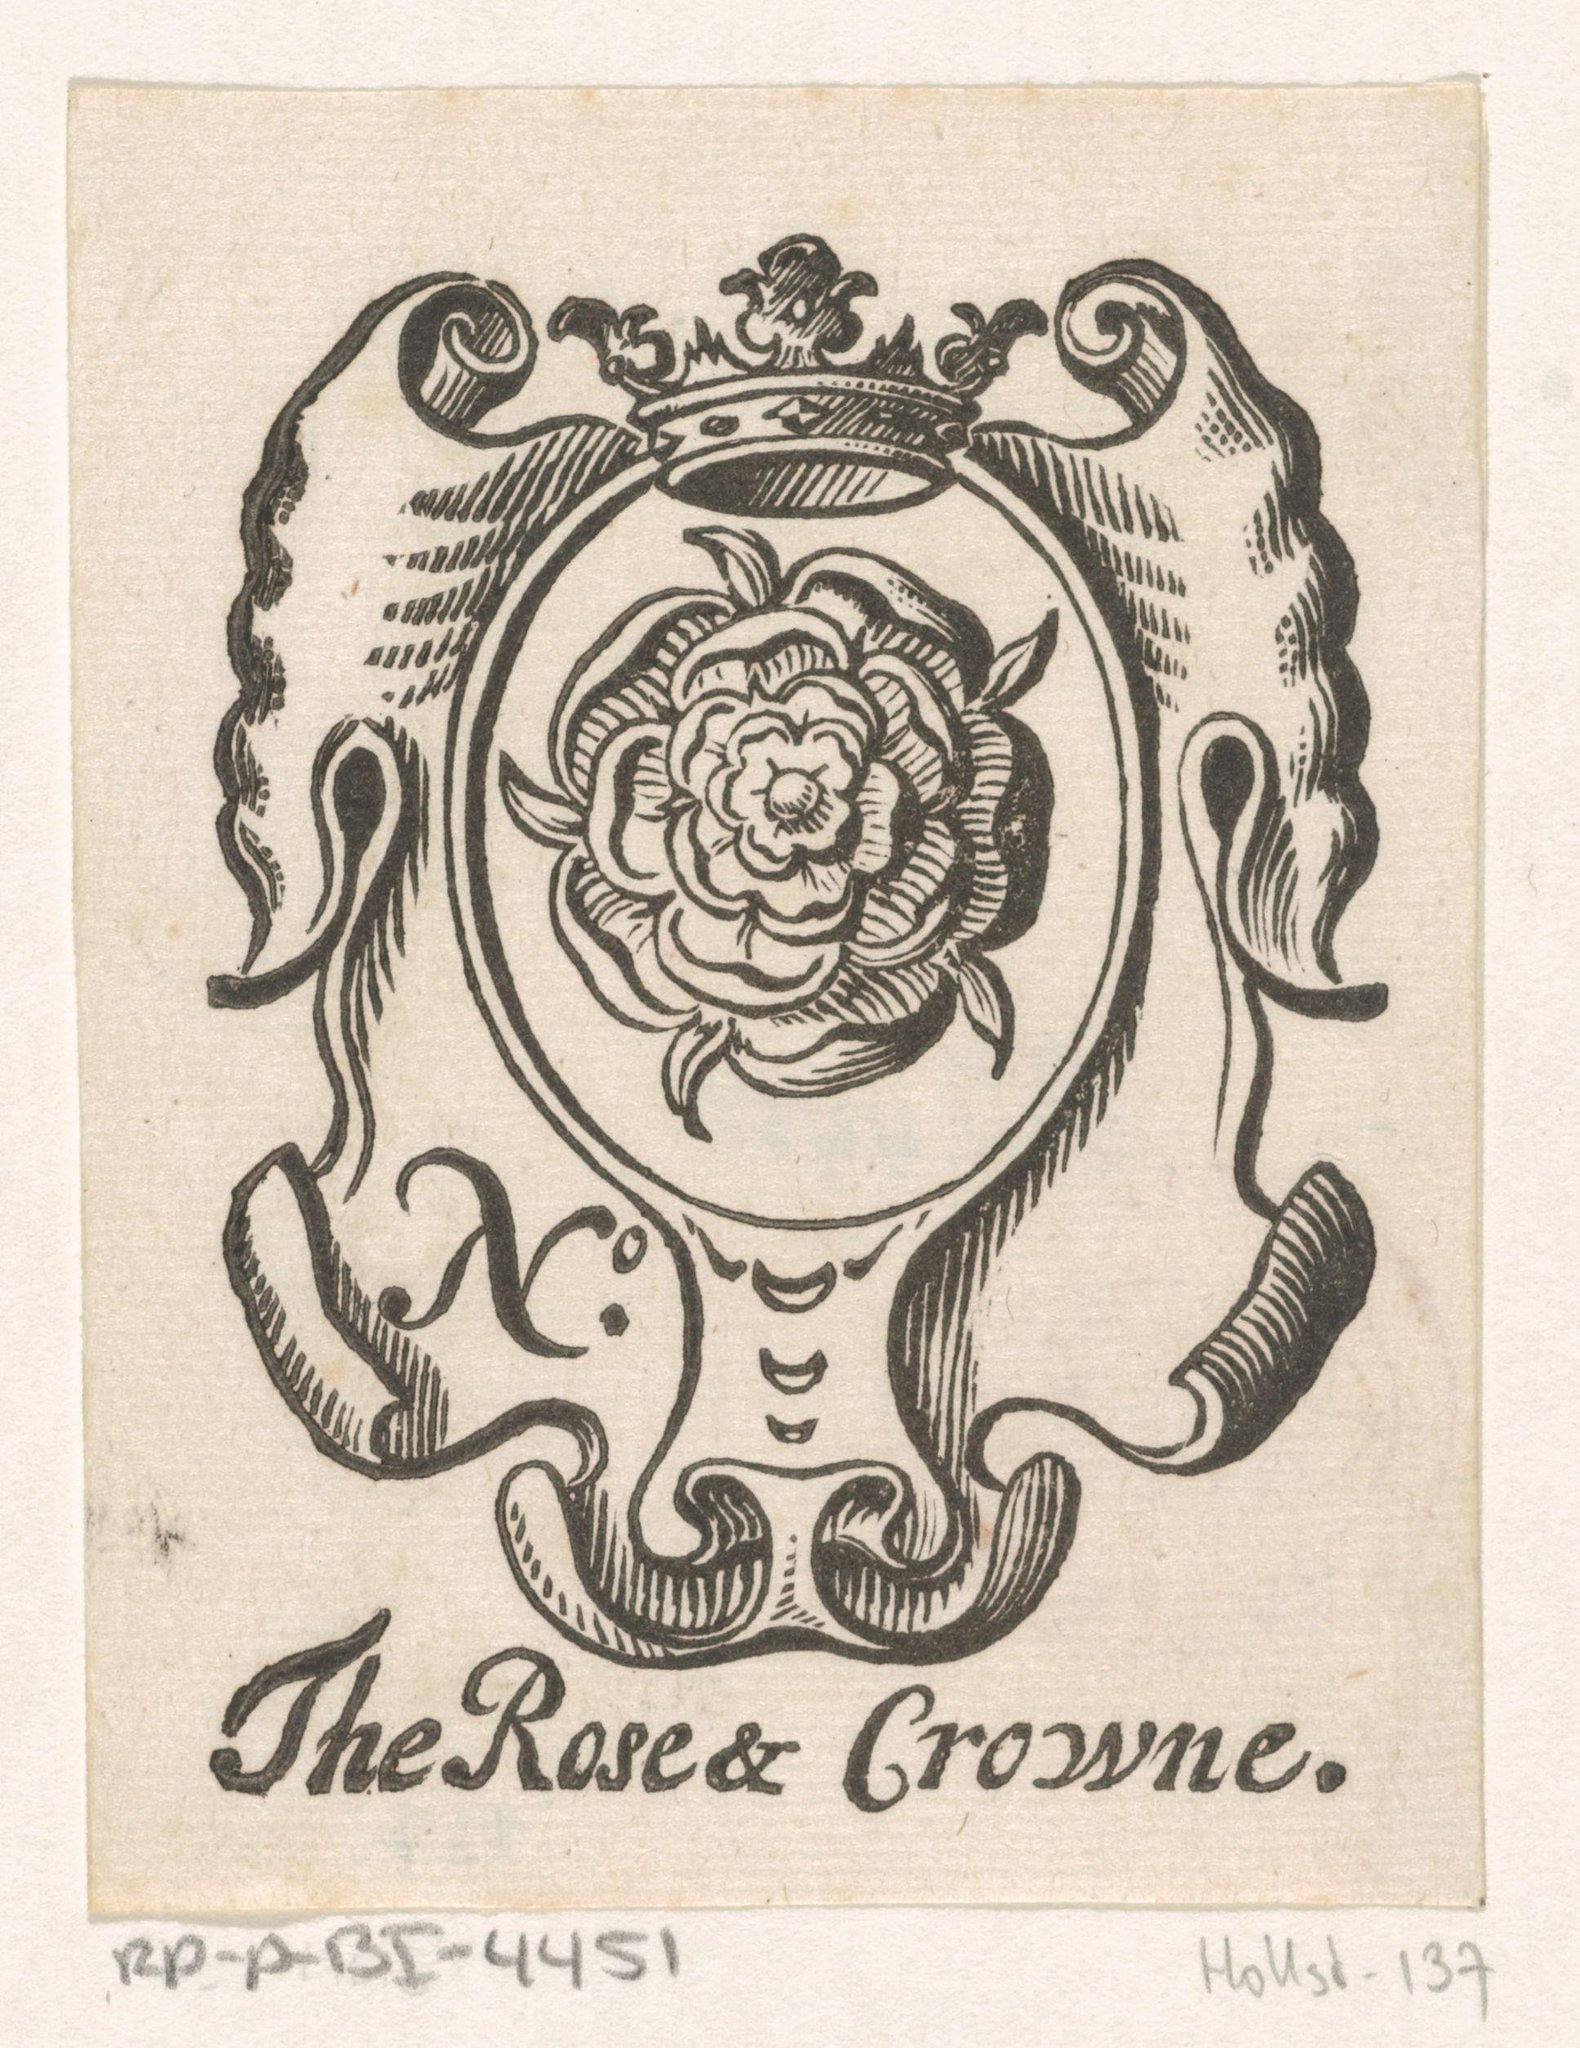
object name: handelsetiket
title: Handelsetiket met een roos en een kroon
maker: isaac vincentsz. van der vinne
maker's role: draughtsman, print maker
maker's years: 1665-1740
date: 1681-1740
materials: paper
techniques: woodcut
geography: haarlem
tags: crown (symbol of sovereignty), flowers: rose, vignette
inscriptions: collector's mark: Lugt 240